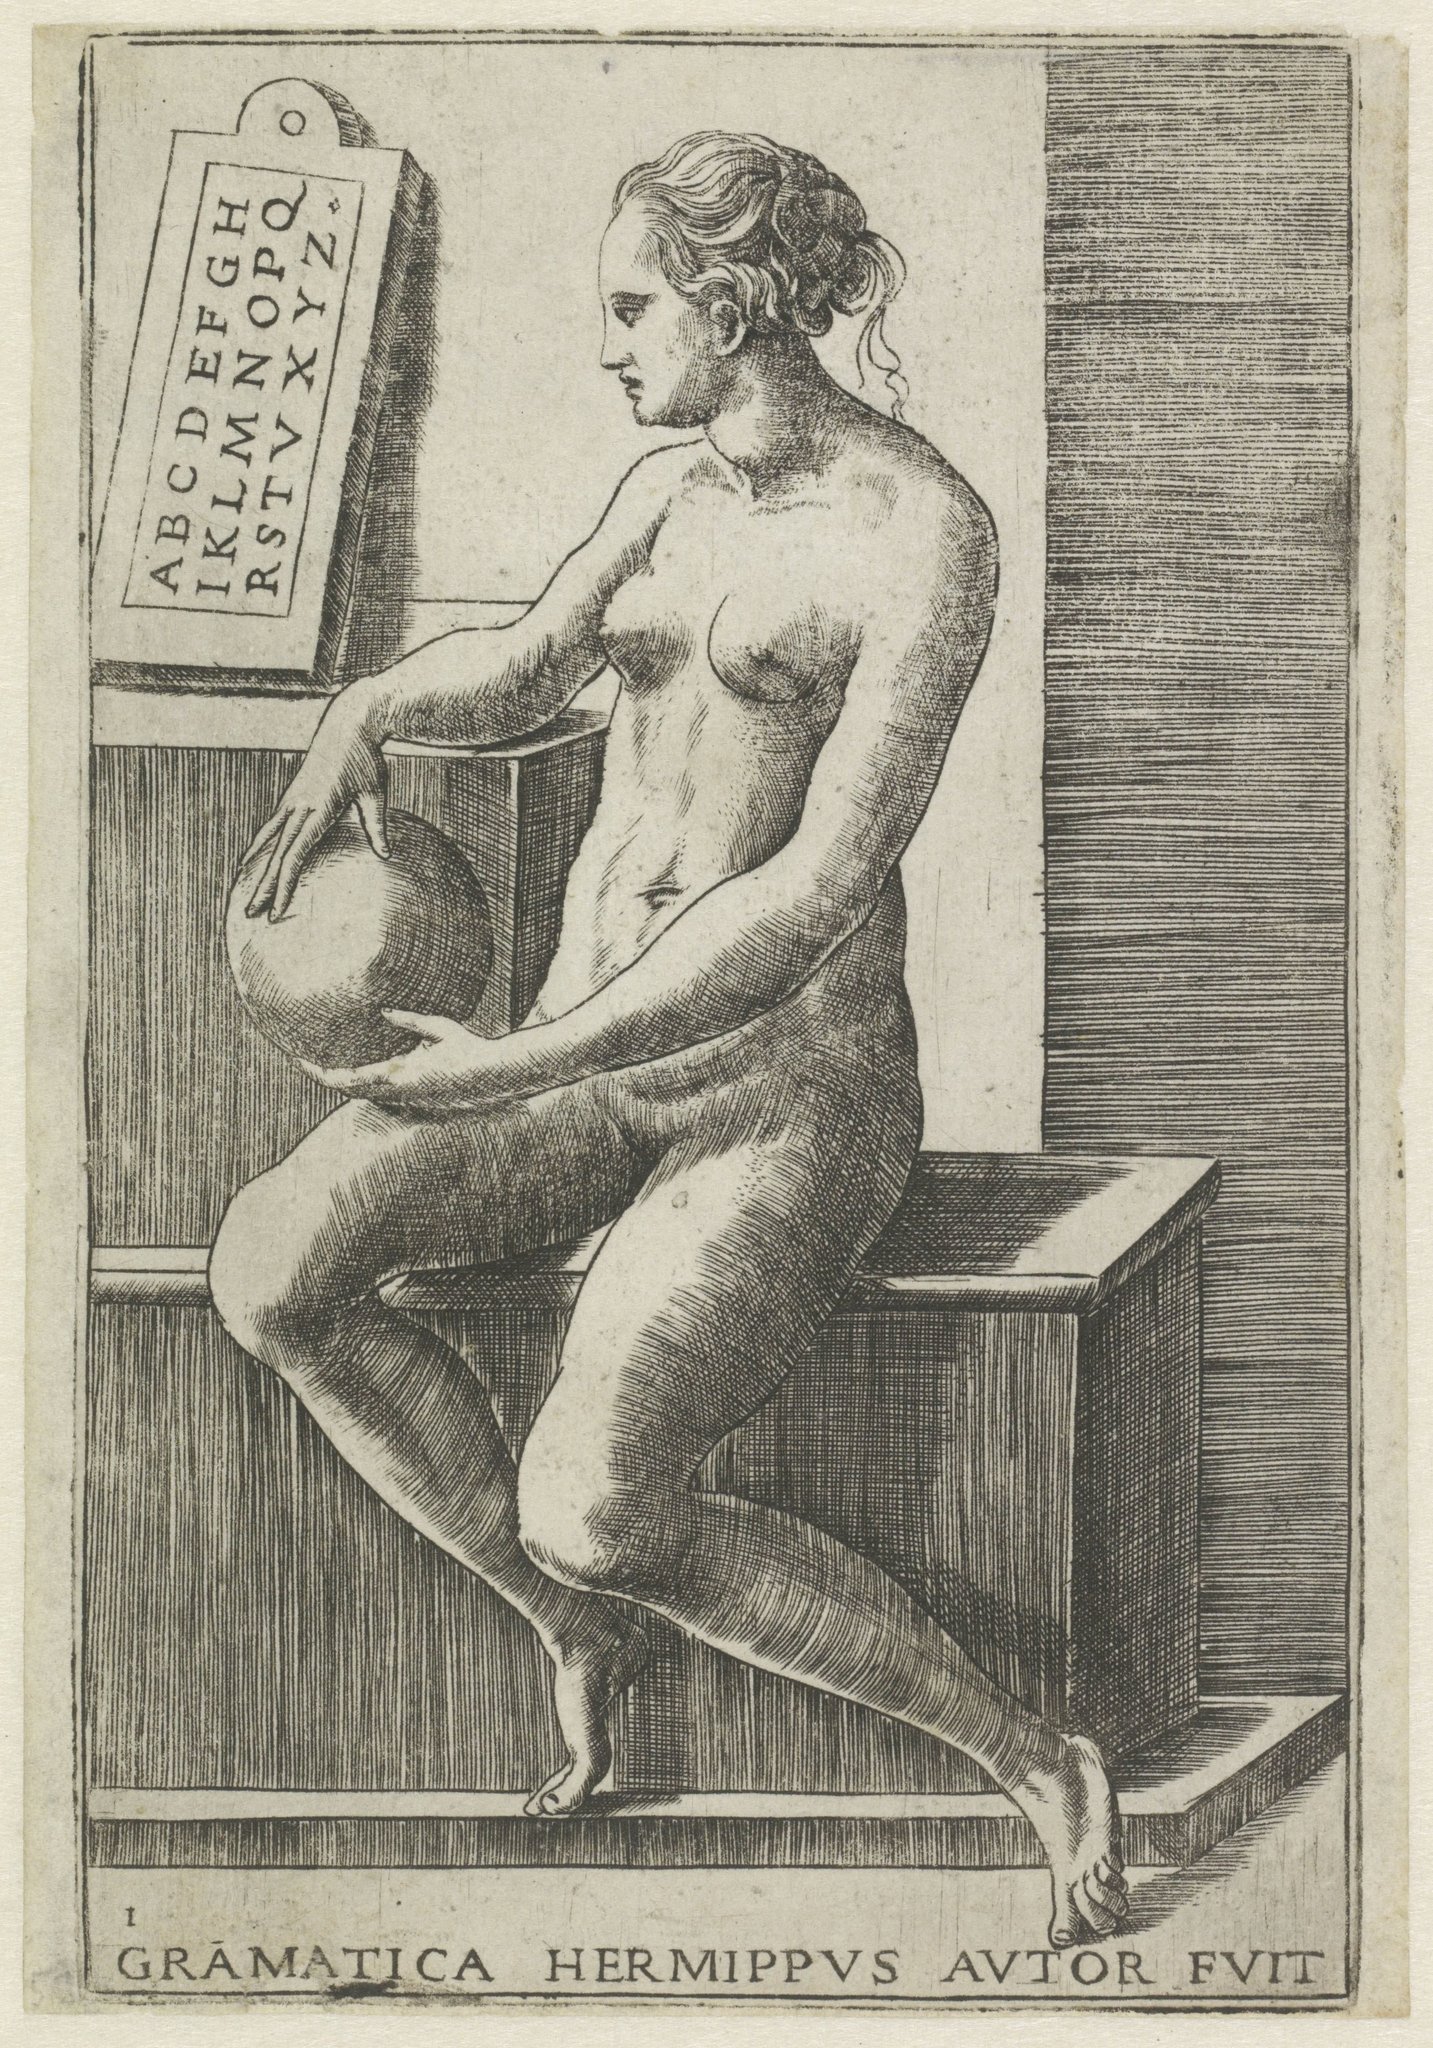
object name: print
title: Grammatica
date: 1544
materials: paper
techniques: engraving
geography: italy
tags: the liberal arts, 'artes liberales', letters, alphabet, script, 'grammatica' (~ trivium); 'grammatica' (ripa)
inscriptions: collector's mark: Lugt 2760, collector's mark: Lugt 2228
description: Personificatie van grammatica: zittende naakte vrouw met bol in de handen. Naast haar een schrijftablet waarop het alfabet.